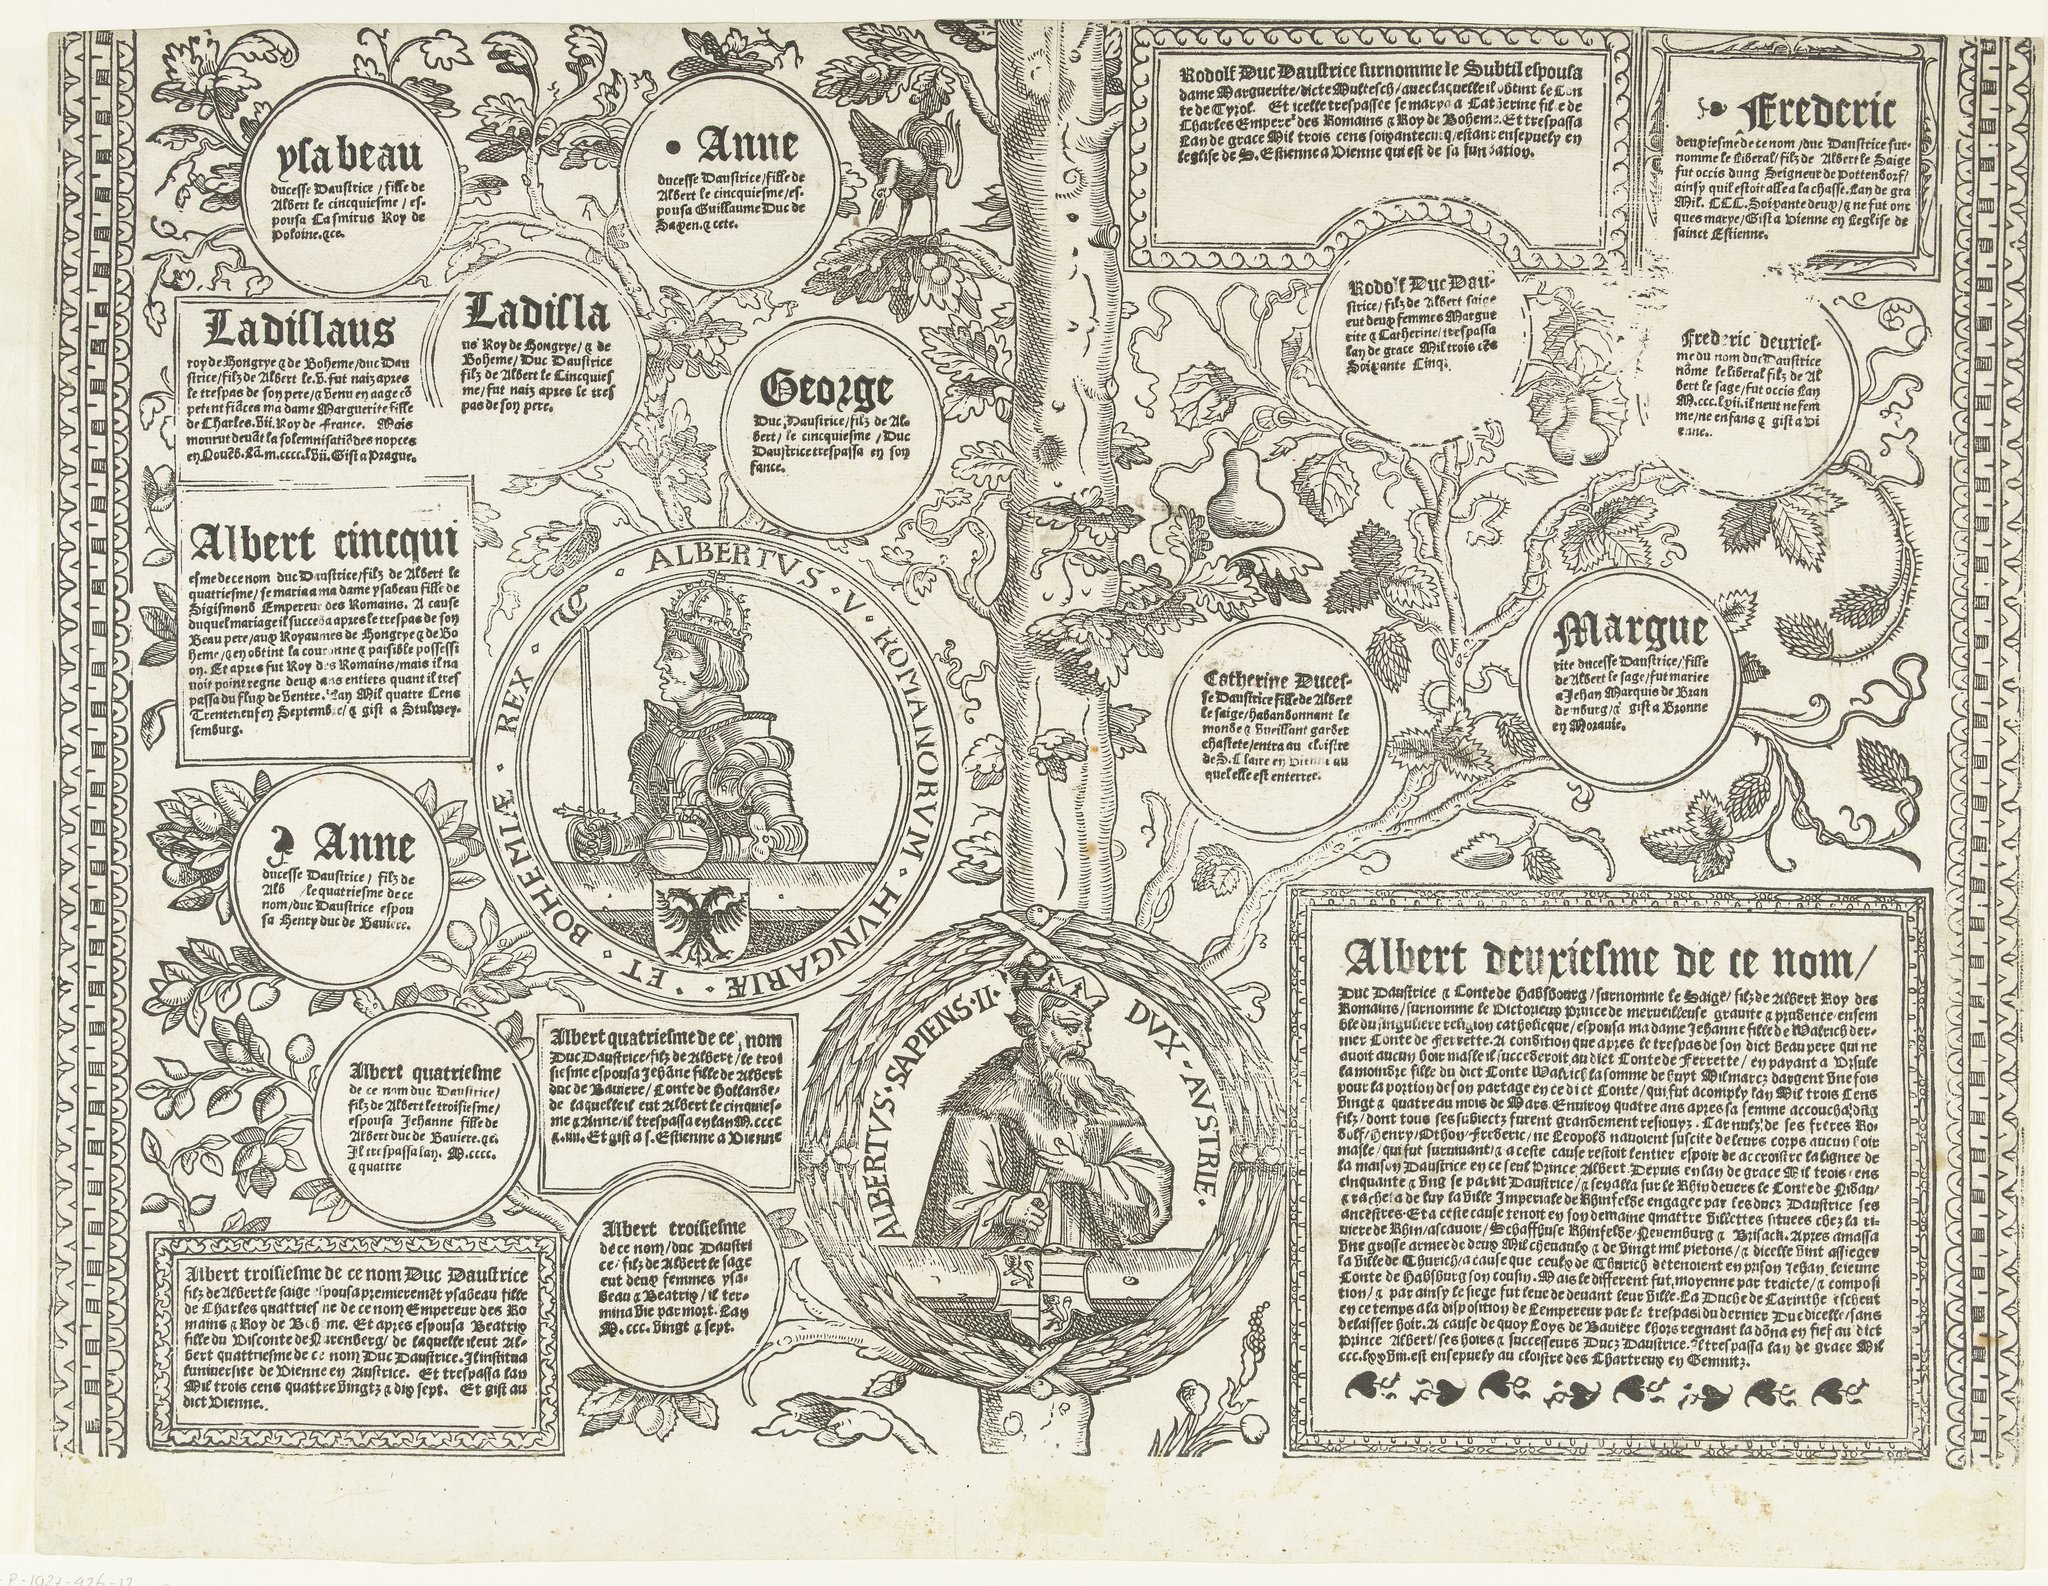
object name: print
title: Stamboom van het Habsburgse Huis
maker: robert péril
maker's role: draughtsman, print maker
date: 1533-1535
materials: paper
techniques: woodcut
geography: antwerp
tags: family lineage, pedigree, genealogical tree or table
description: Eén blad van twintig, vormen samen een stamboom. In de boom twee medaillons met Albrecht II, hertog van Oostenrijk en Albrecht V (II) koning van het Heilige Roomse Rijk. Elf kleine medaillons met namen van familieleden en zeven cartouches met teksten in het Frans.